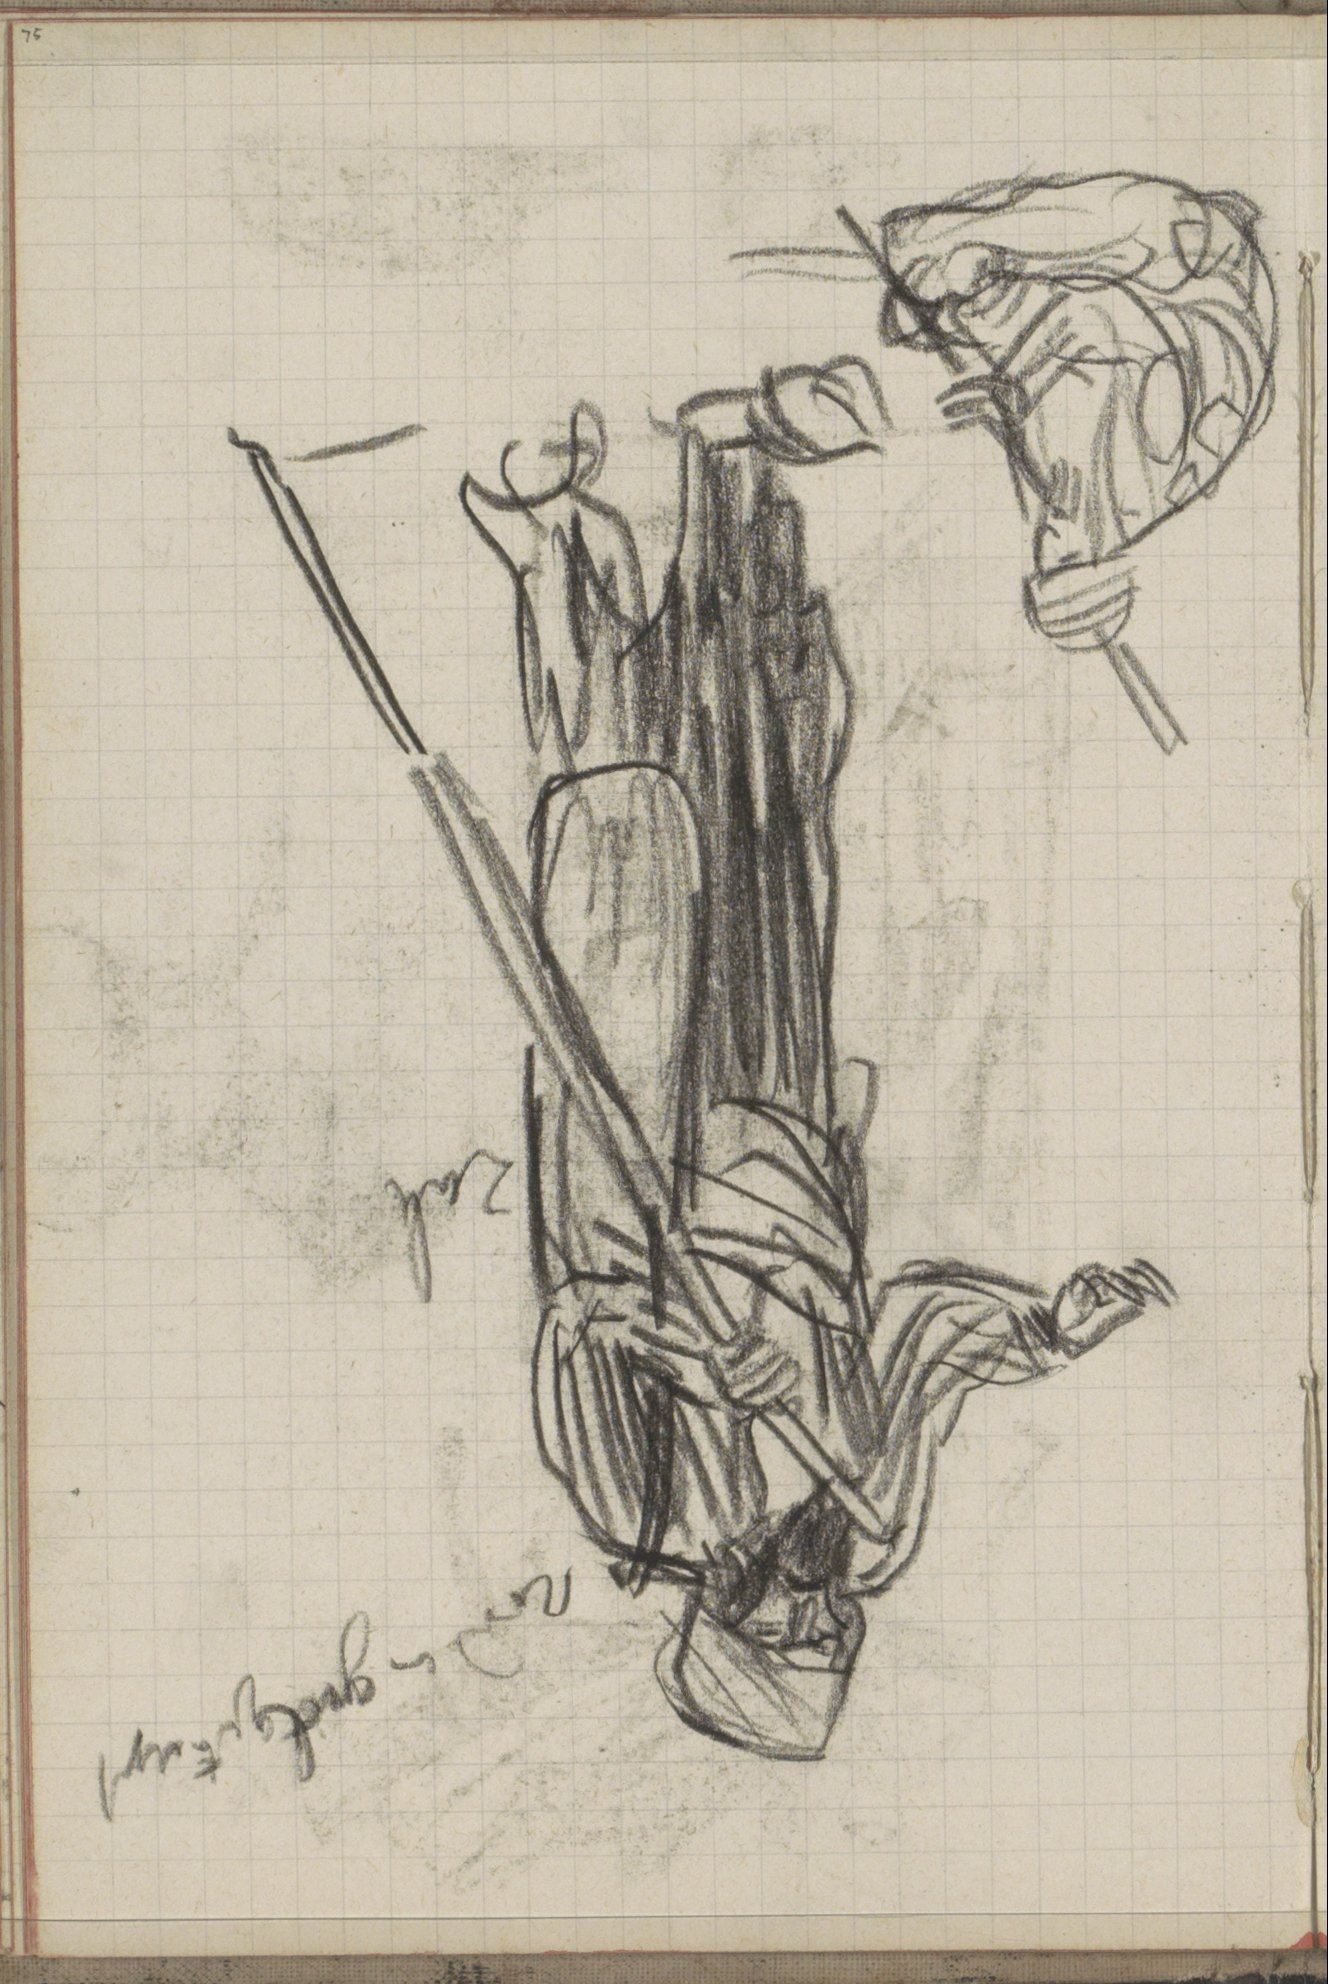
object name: sketchbook leaf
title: Staande en zittende bedelaar met staf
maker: marius bauer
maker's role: draughtsman, print maker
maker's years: 1867-1932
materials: chalk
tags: asiatic races and peoples, standing figure, sitting figure, walking-stick, staff, beggar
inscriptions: annotation: ‘zak’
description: Man in oosterse kleding met baard en zak, de rechterhand uitgestoken. Pagina 75 uit een schetsboek met 54 bladen.